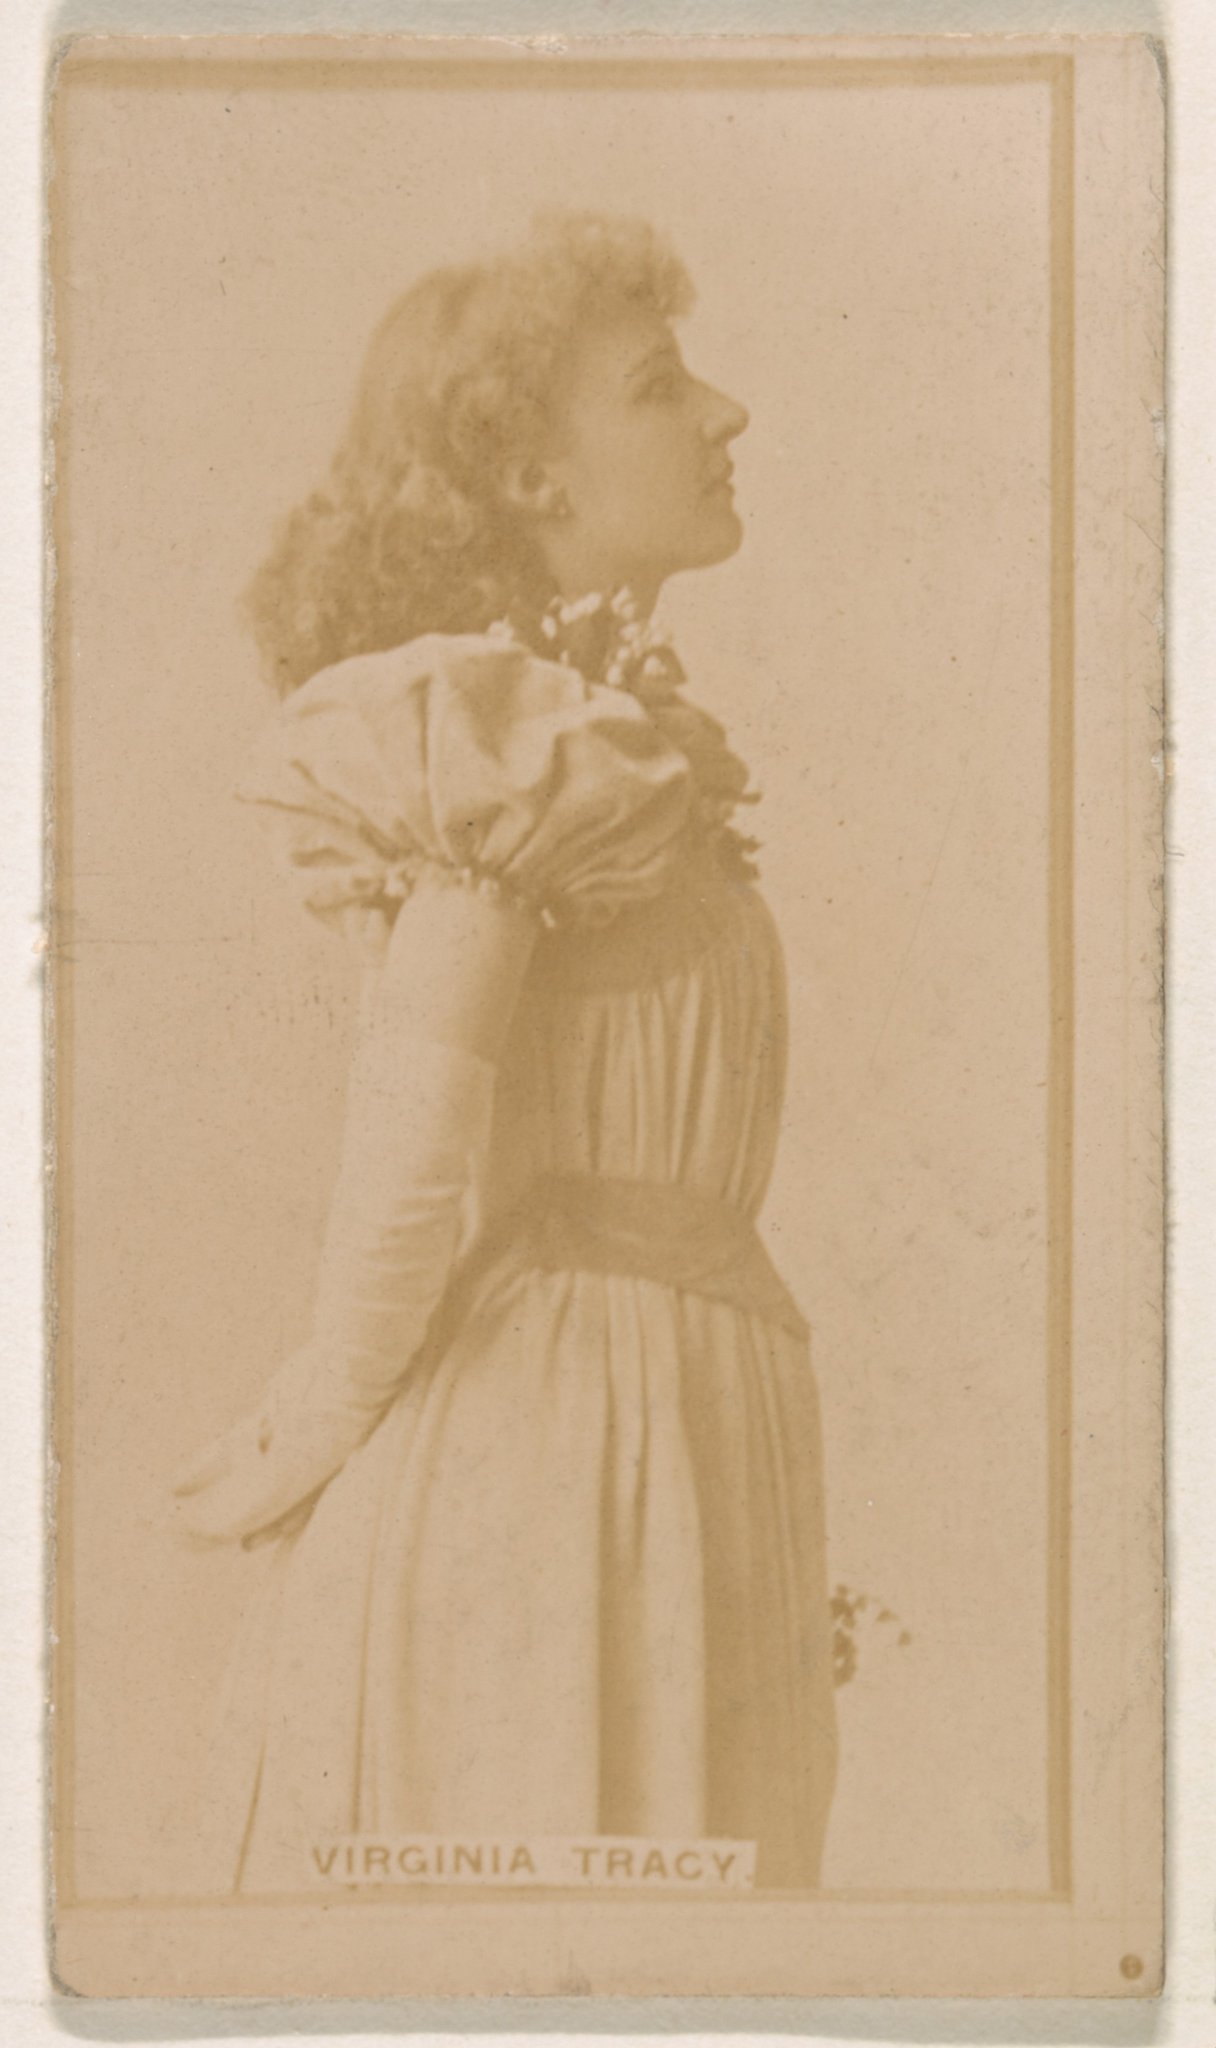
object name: photograph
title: Virginia Tracy, from the Actresses series (N245) issued by Kinney Brothers to promote Sweet Caporal Cigarettes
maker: kinney brothers tobacco company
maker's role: publisher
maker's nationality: american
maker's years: 1869-2011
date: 1890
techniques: albumen silver print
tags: women,actresses